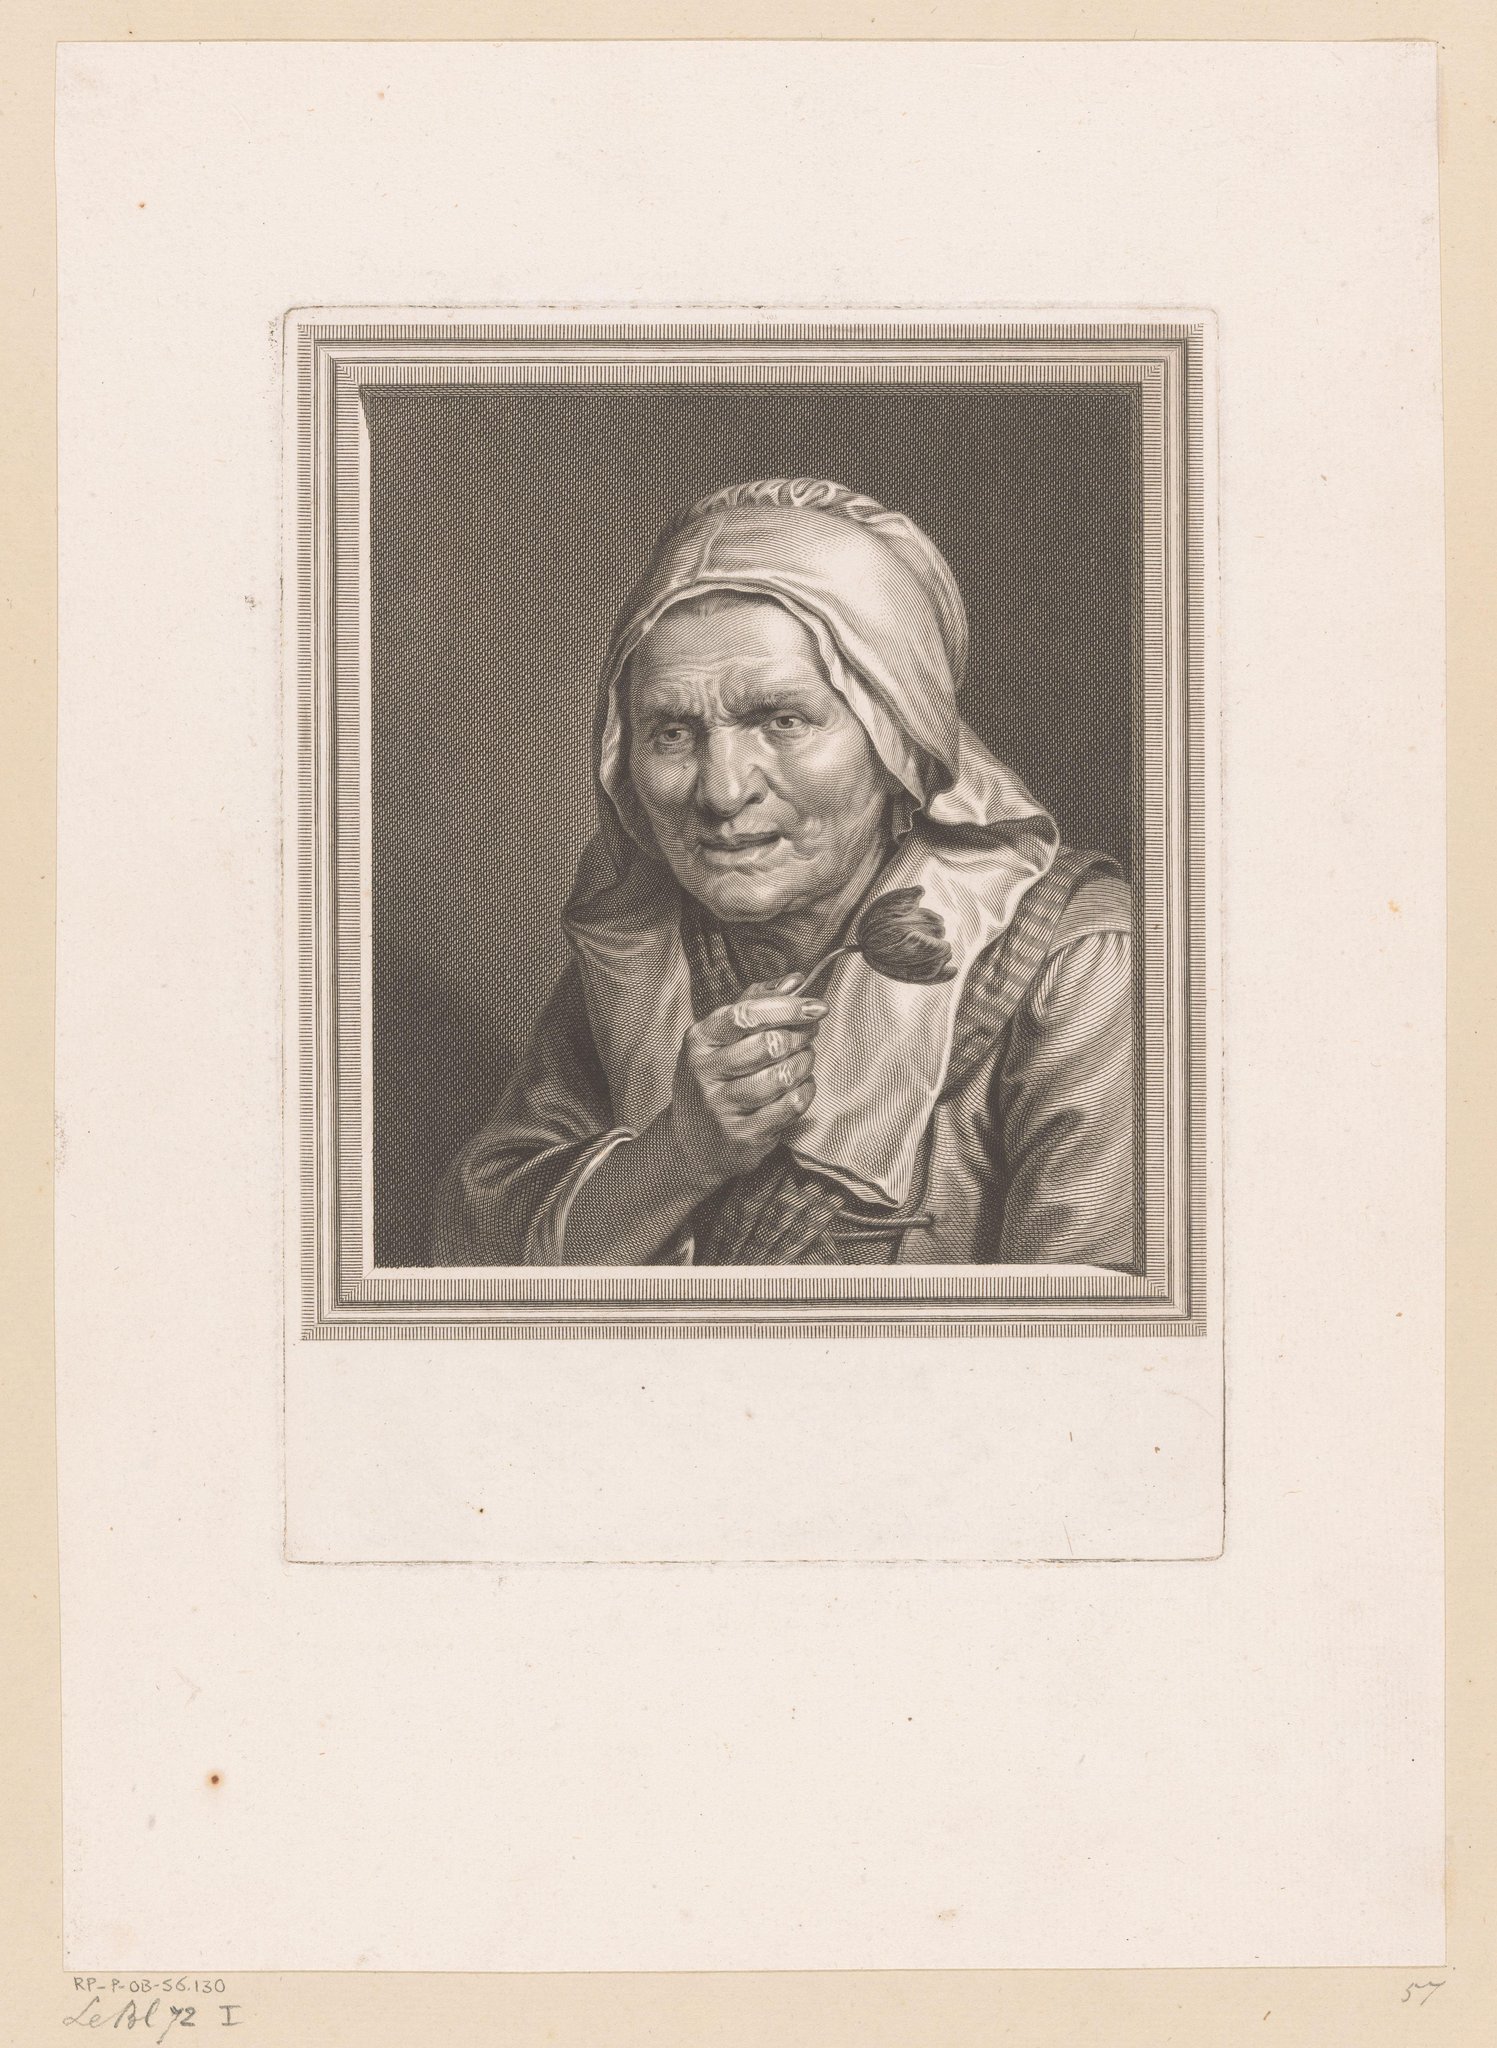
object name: print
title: Soeur de la bonne femme de Normandie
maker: johann georg wille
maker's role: draughtsman, print maker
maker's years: 1715-1808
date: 1774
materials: paper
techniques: engraving, etching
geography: paris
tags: old woman, head-gear: cap, flowers: tulip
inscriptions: collector's mark: Lugt 240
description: Deze prent maakt deel uit van een serie van onbekende omvang naar Nederlandse en Duitse schilderijen. Op sommige prenten staat linksboven aangegeven welk nummer in de serie het betreft.